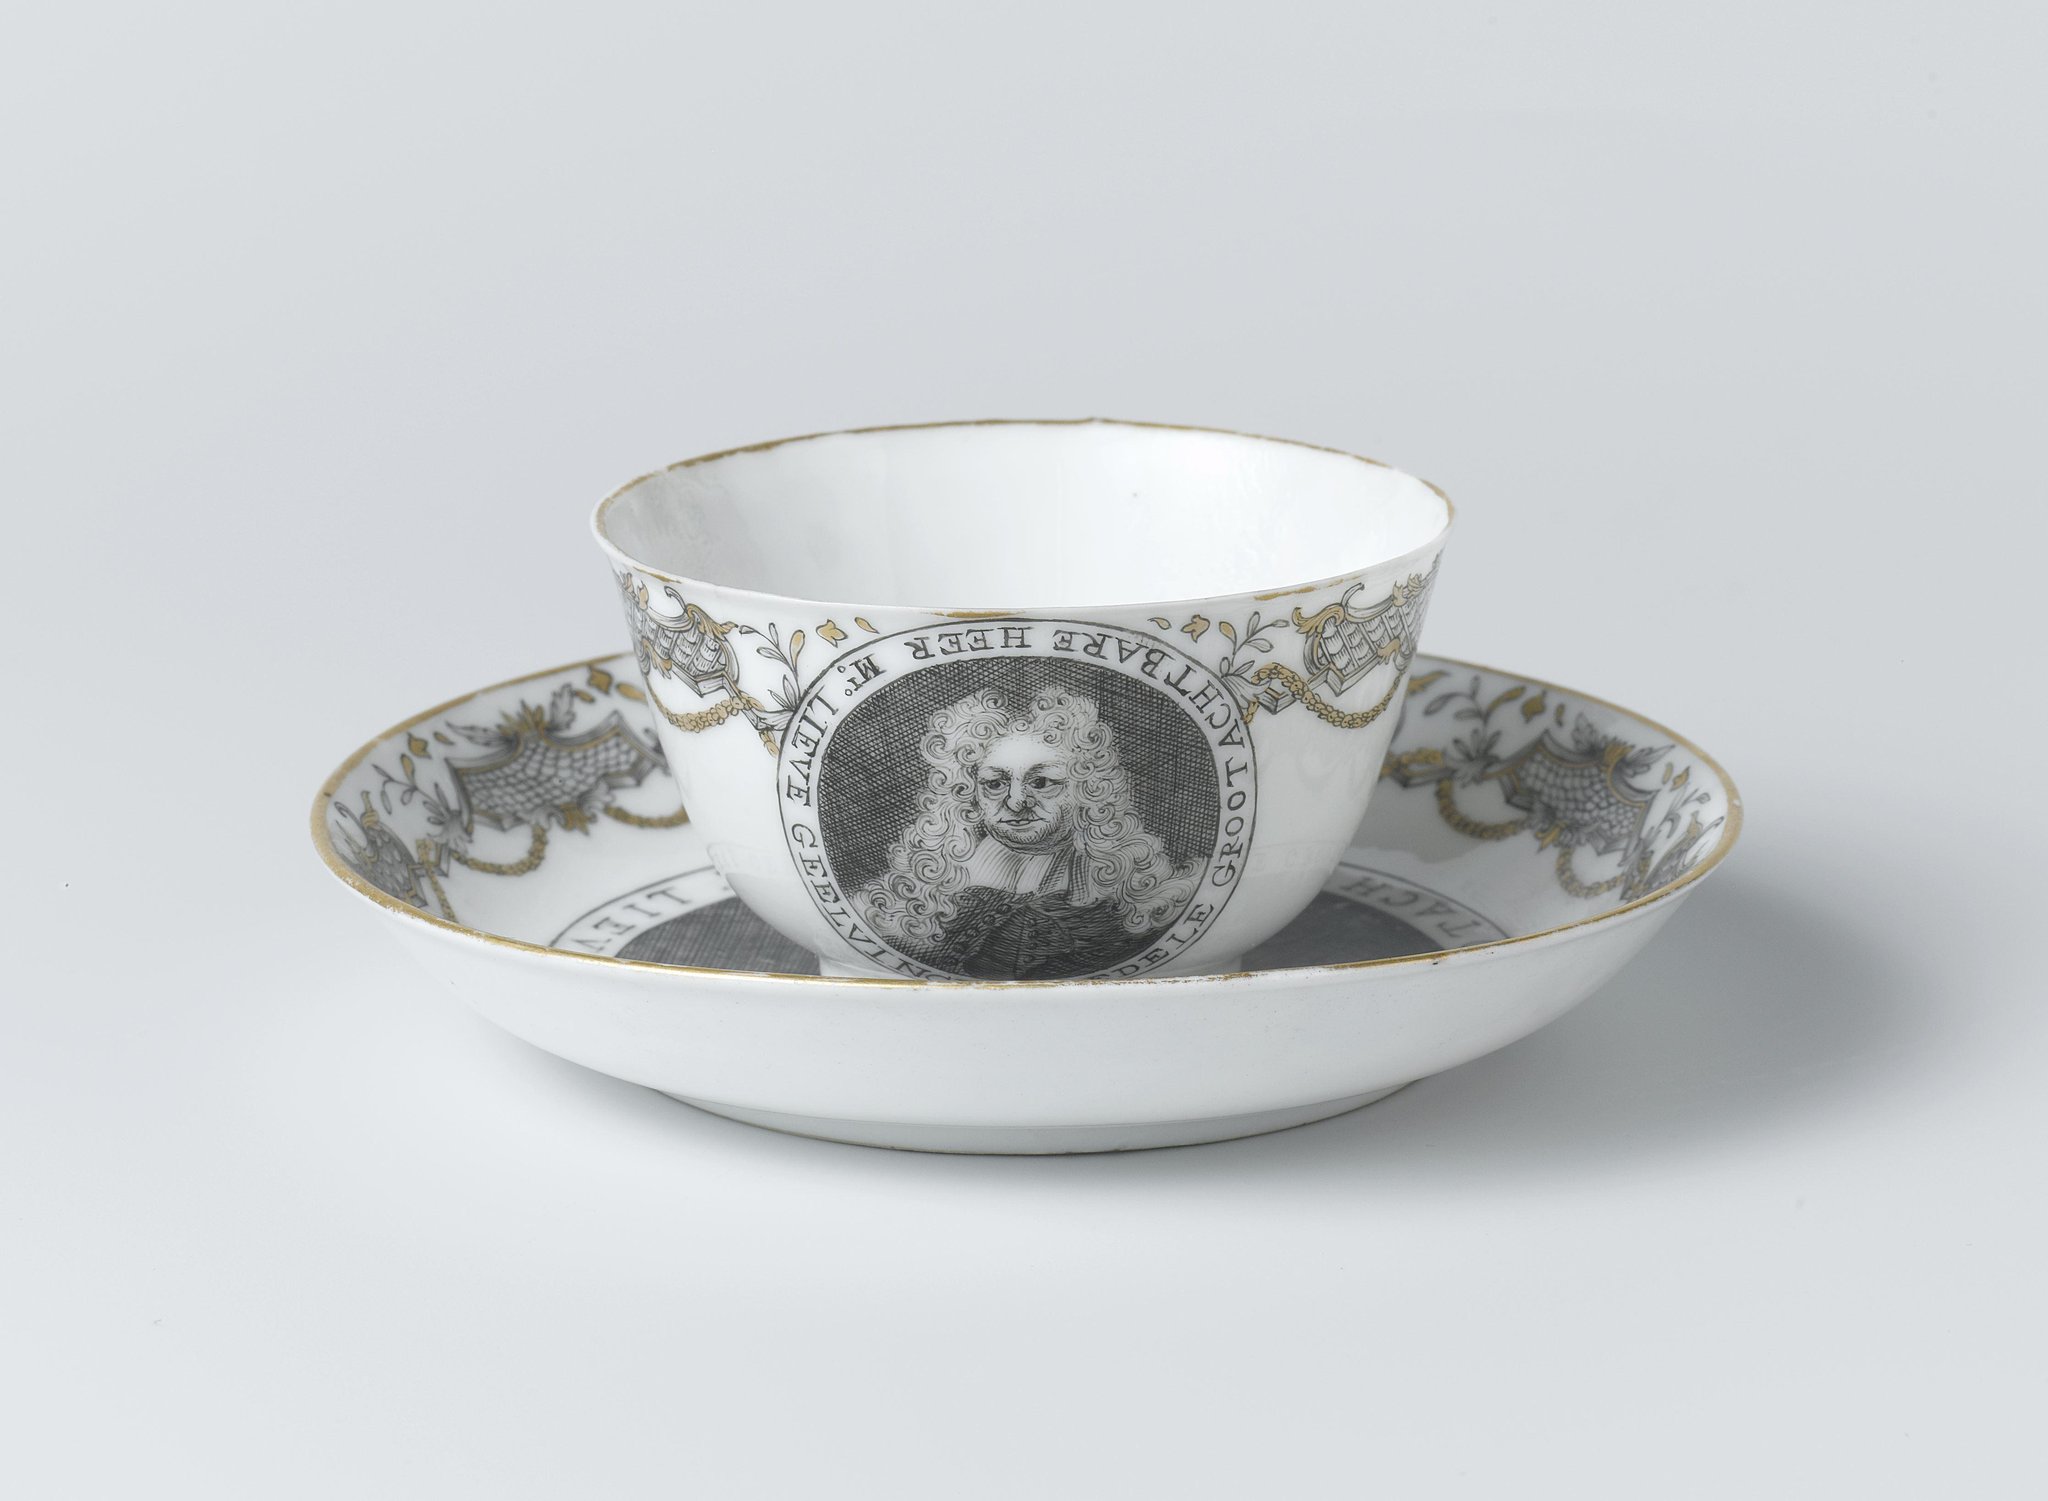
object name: kop en schotel, kop en schotel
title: Bell-shaped cup and saucer with a portrait of Lieve Geelvinck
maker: Anonymous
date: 1760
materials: glaze, gold, paint, porcelain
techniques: firing, gilding, turning, vitrification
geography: netherlands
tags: mayor, lieve geelvinck, amsterdam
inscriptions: inscription: ‘DE EDELE GROOTACHTBARE HEER Mr. LIEVE GEELVINCK’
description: Het portret is een nauwkeurige kopie naar een gravure uit 1758 door Jacob Houbraken (1698-1780) en gebaseerd op een schilderij van Jan Wandelaar (1690-1759). Geelvinck was naast burgemeester van Amsterdam ook één van de directeuren van de VOC. Dit bood hem een uitstekende gelegenheid om Chine de commande porselein in China te laten vervaardigen. Hij bezat eveneens een polychroom servies voorzien van zijn wapen. Ook is een bord bekend met een allegorische voorstelling op zijn huwelijk met Jacoba Graafland in 1729. (C.J.A. Jörg en Jan van Campen, Chinese Ceramics in the Rijksmuseum, Londen 1997, p. 280)